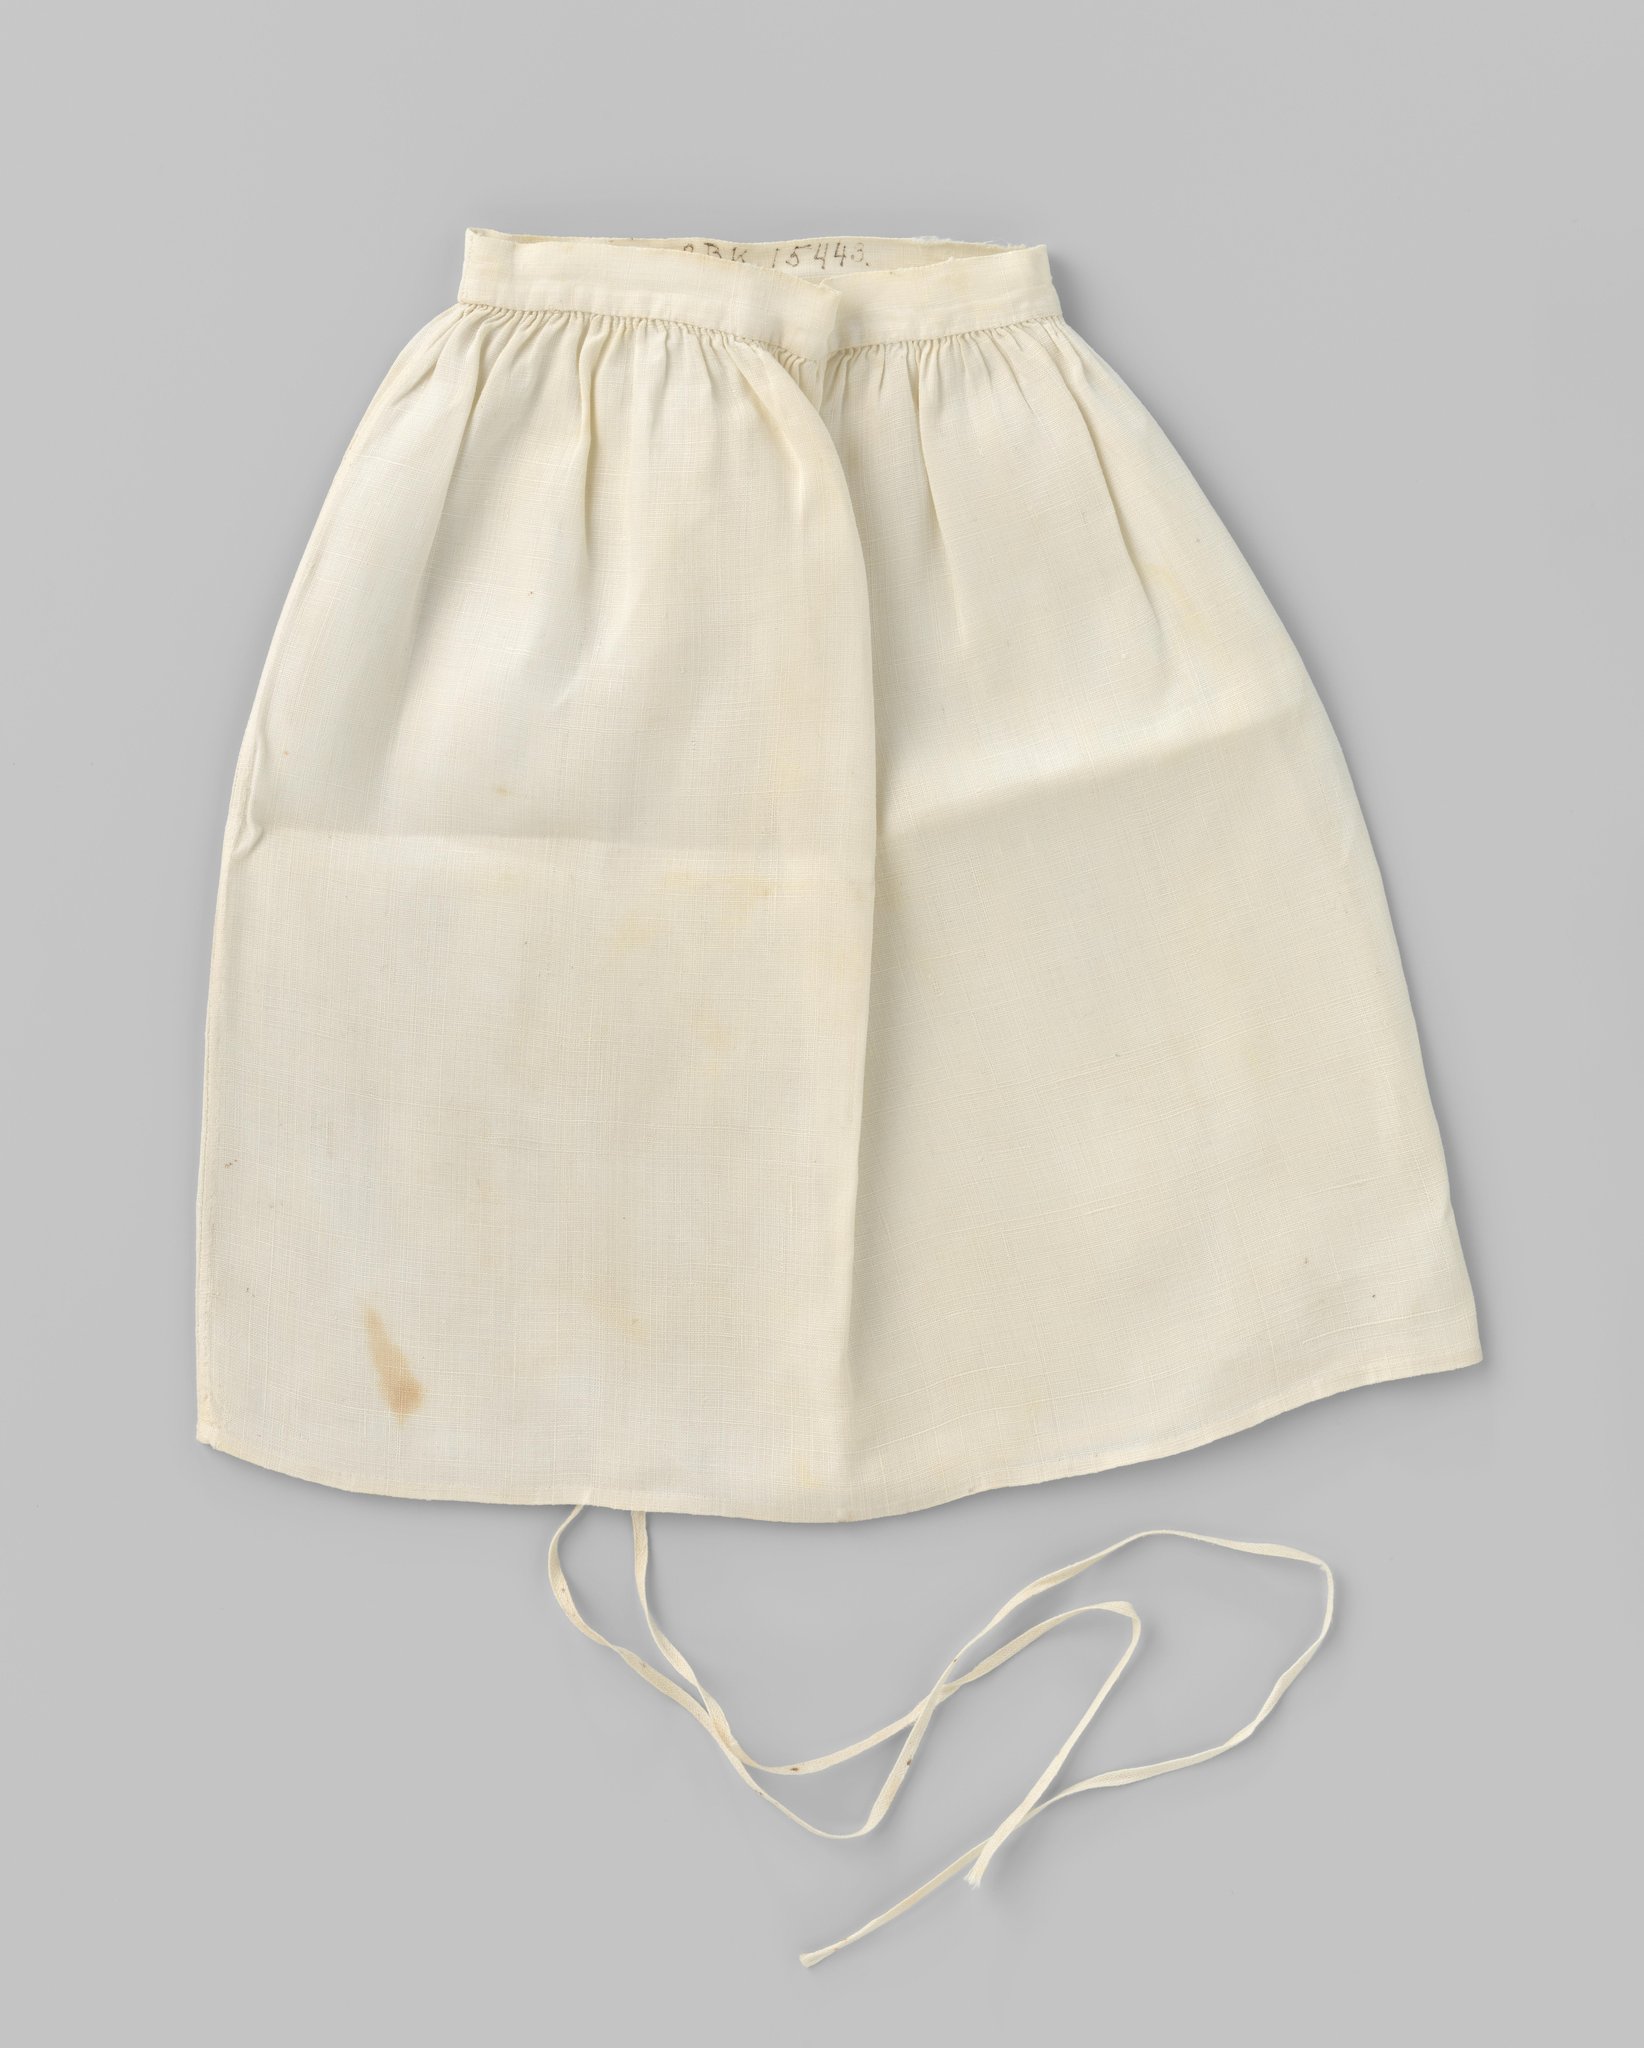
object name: toy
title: Onderrok van wit linnen voor pop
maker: Anonymous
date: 1850-1920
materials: linen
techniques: weave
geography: netherlands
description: Aan de onderzijde zijn vlak naast elkaar twee witte linten bevestigd.